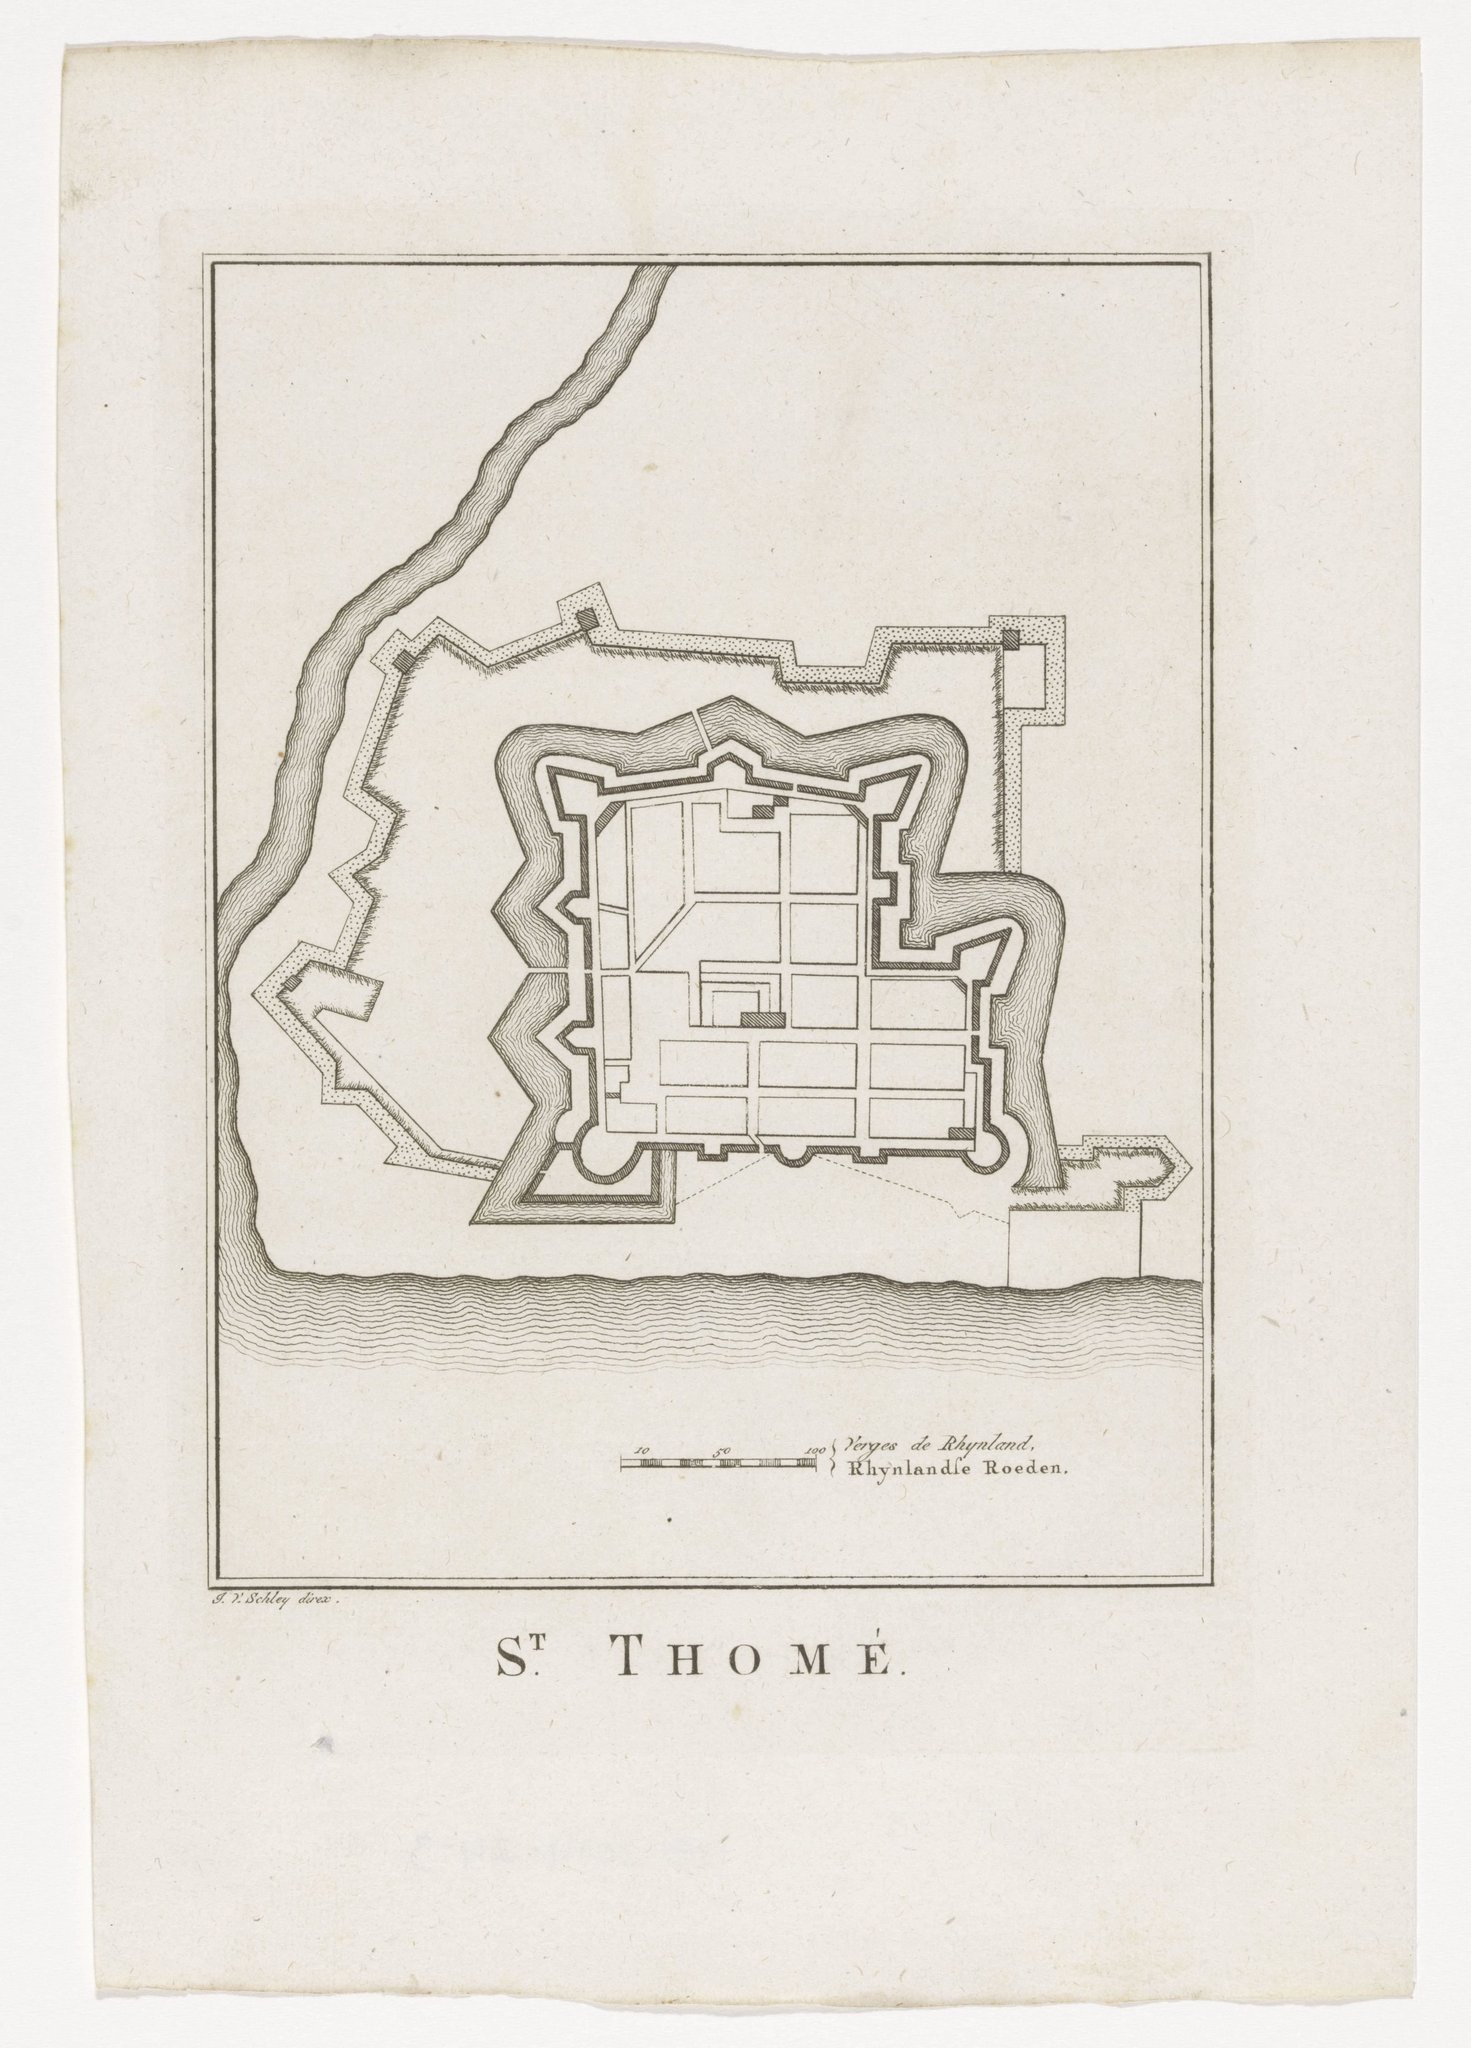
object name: print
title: Fort op het eiland Sao Thomé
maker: jacob van der schley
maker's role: draughtsman, print maker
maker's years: 1715-1779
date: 1747-1780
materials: paper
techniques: etching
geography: northern netherlands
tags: verenigde oostindische compagnie, sao tomé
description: Gebruikt als illustratie in: A.F. Prévost, Histoire générale des voyages, ou Nouvelle collection de toutes les relations de voyages par mer et par terre ..., 25 dln 1747-1780, Den Haag: Pieter de Hondt.